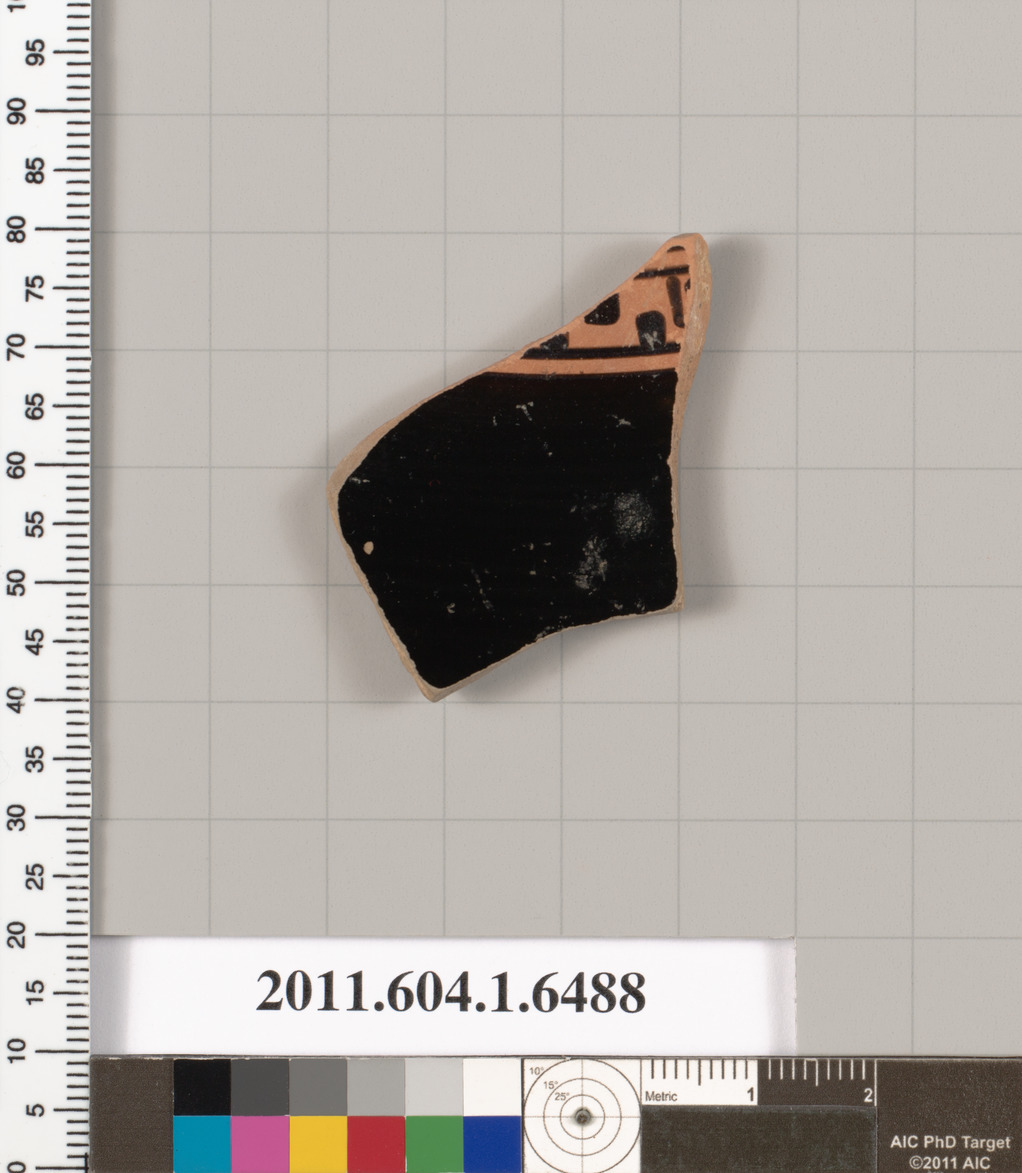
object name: kylix fragment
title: Terracotta fragment of a kylix (drinking cup)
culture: greek, attic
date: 490-480 BCE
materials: terracotta